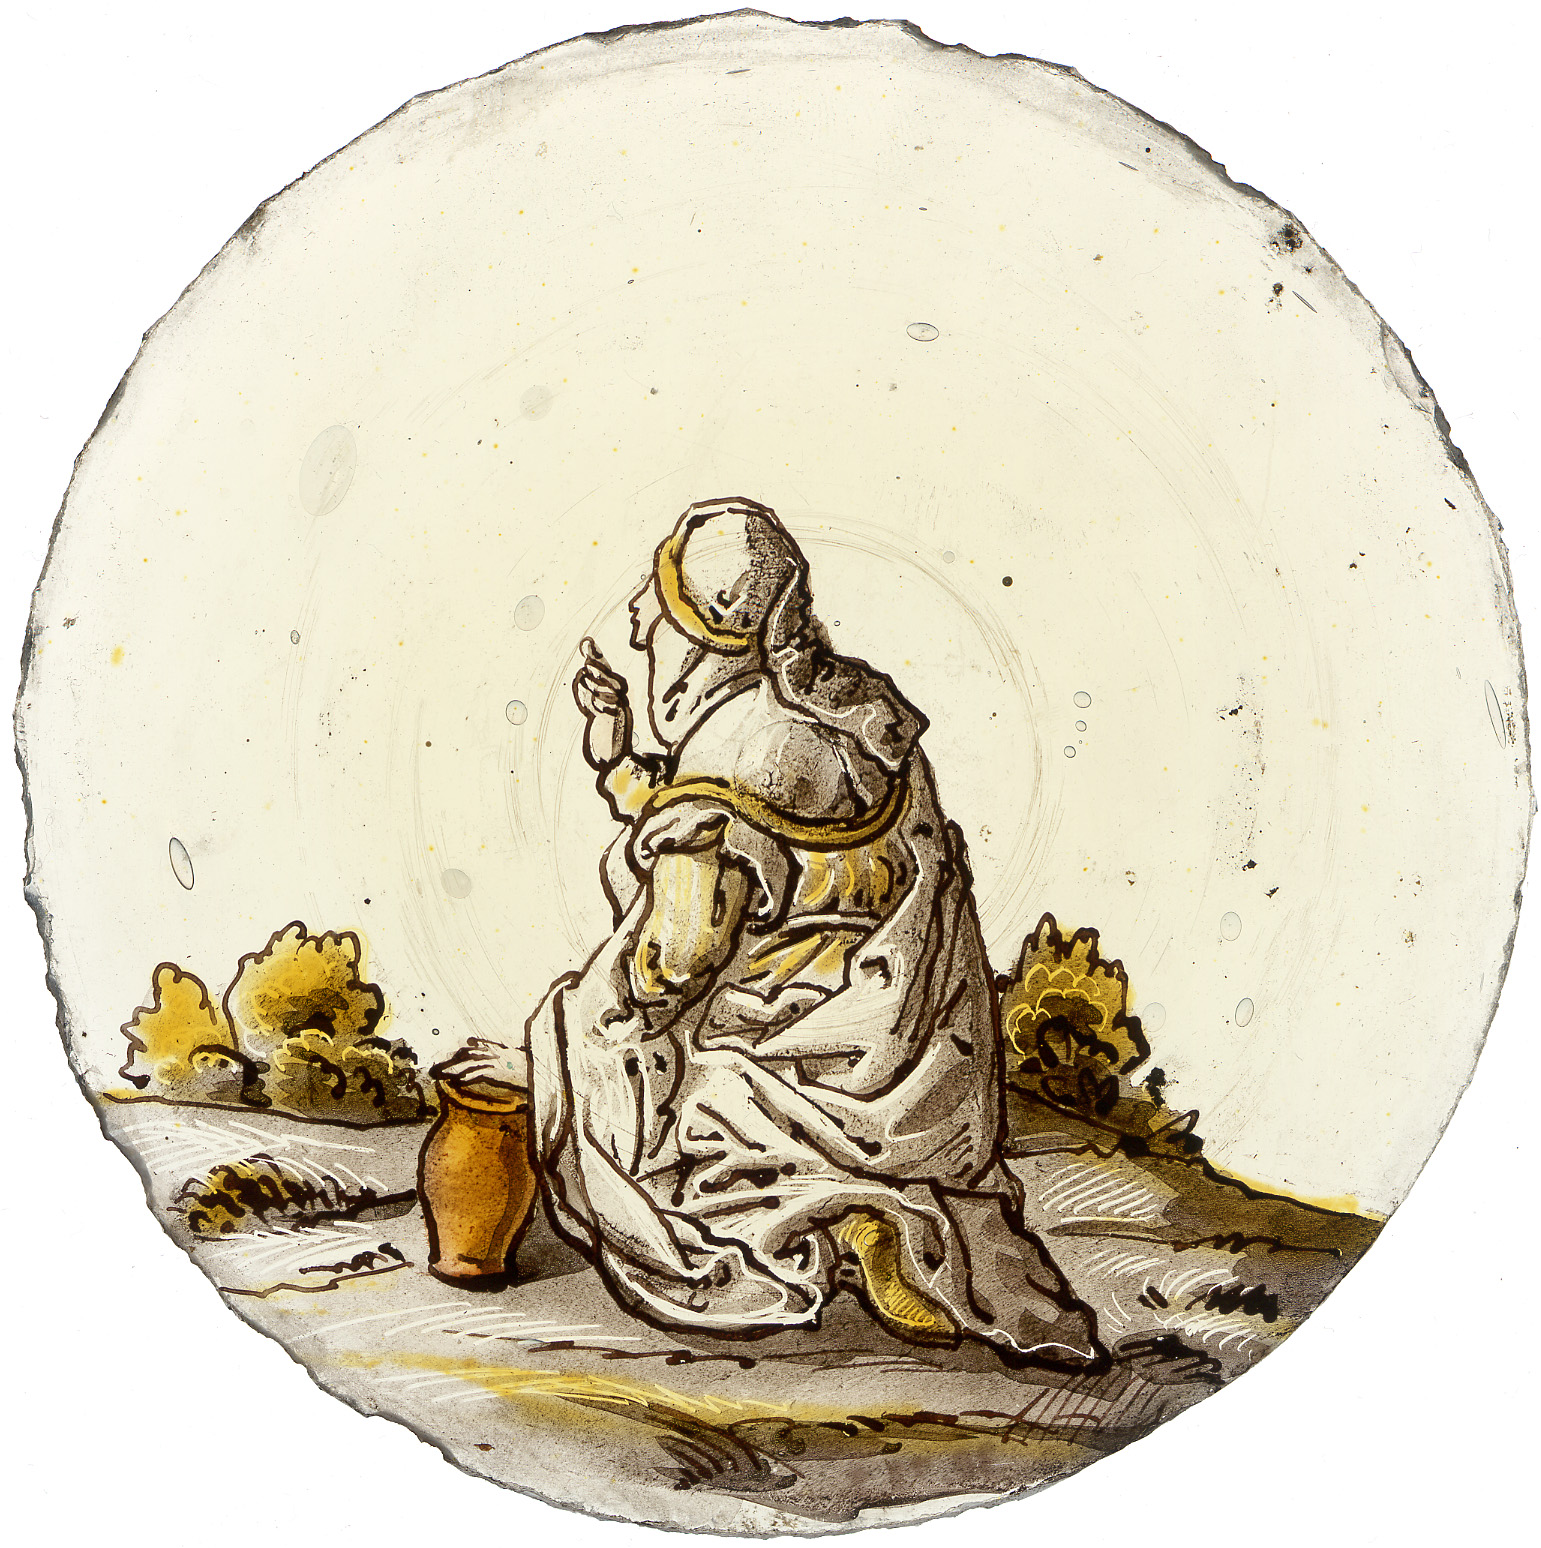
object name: roundel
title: Saint Mary Magdalene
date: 1601-1800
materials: glass, paint, pigment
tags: mary magdalene